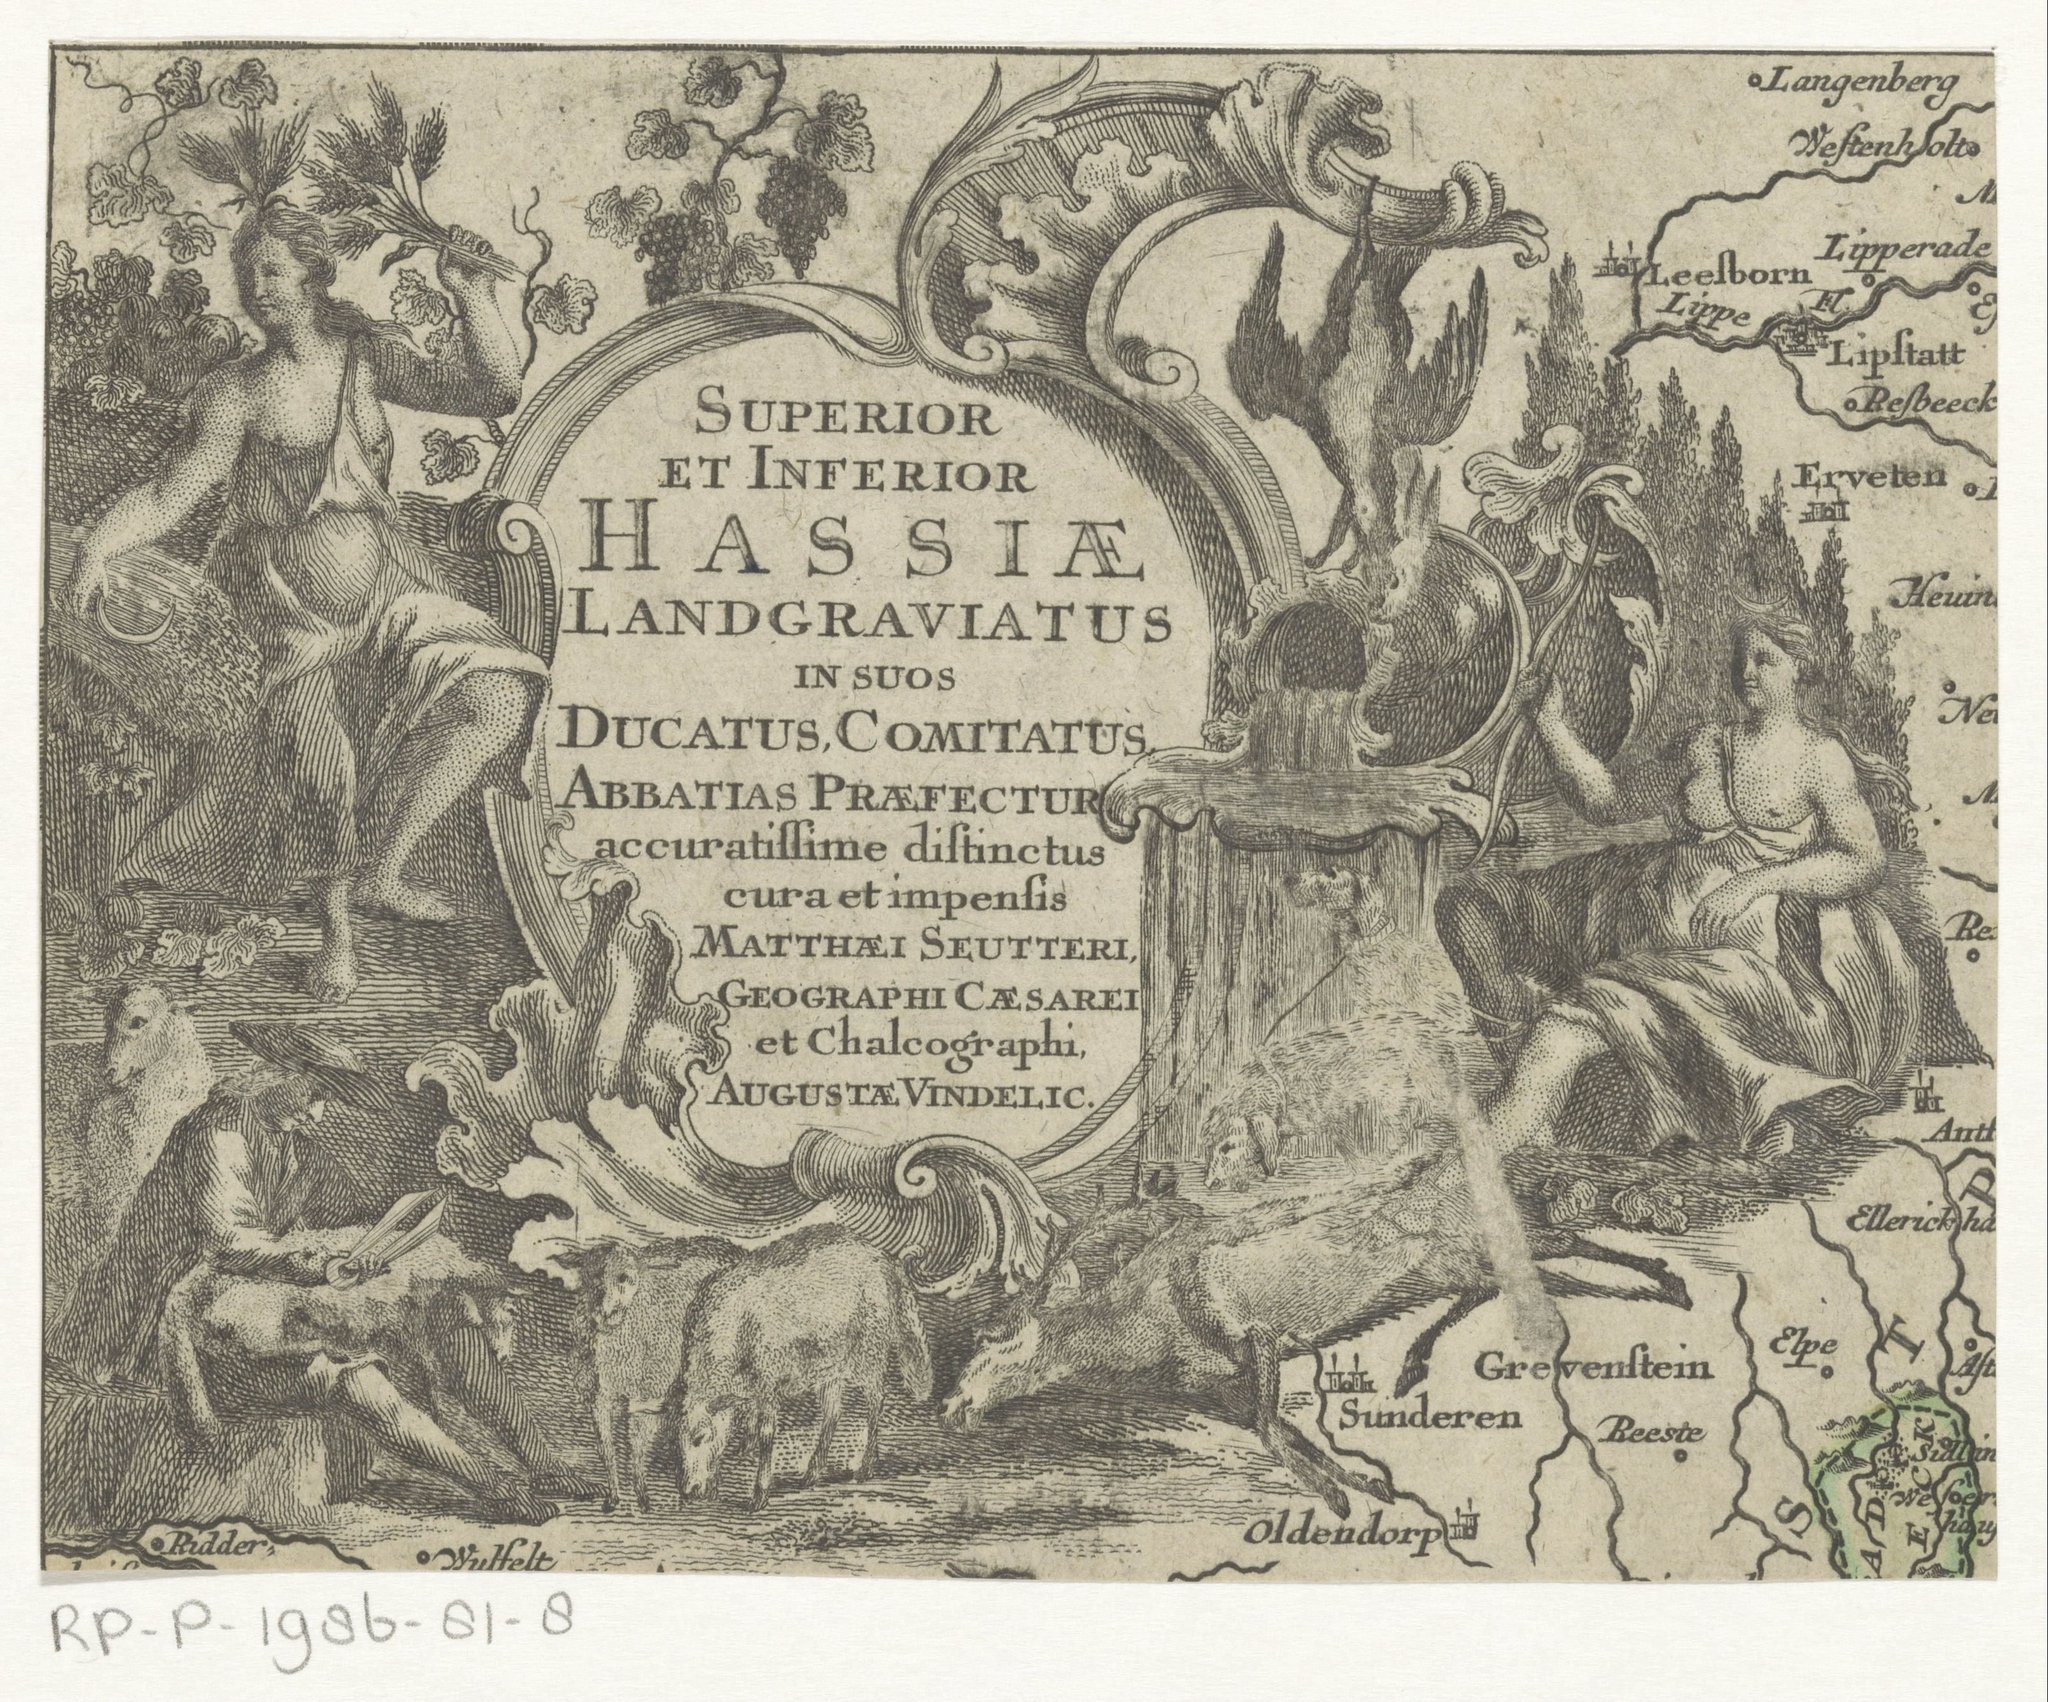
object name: print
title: Ceres, Diana en schapenscheerder rondom cartouche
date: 1707-1757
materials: paper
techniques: engraving, etching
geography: augsburg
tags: (story of) ceres (demeter), (story of) diana (artemis), ornament ~ cartouche, shearing (sheep)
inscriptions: collector's mark: Lugt 2228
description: Ceres met korenaren en sikkel, Diana met halve maan op het hoofd en boog en een schapenscheerder omringen een cartouche met titel. Detail van een kaart van de deelstaat Hessen in Duitsland.